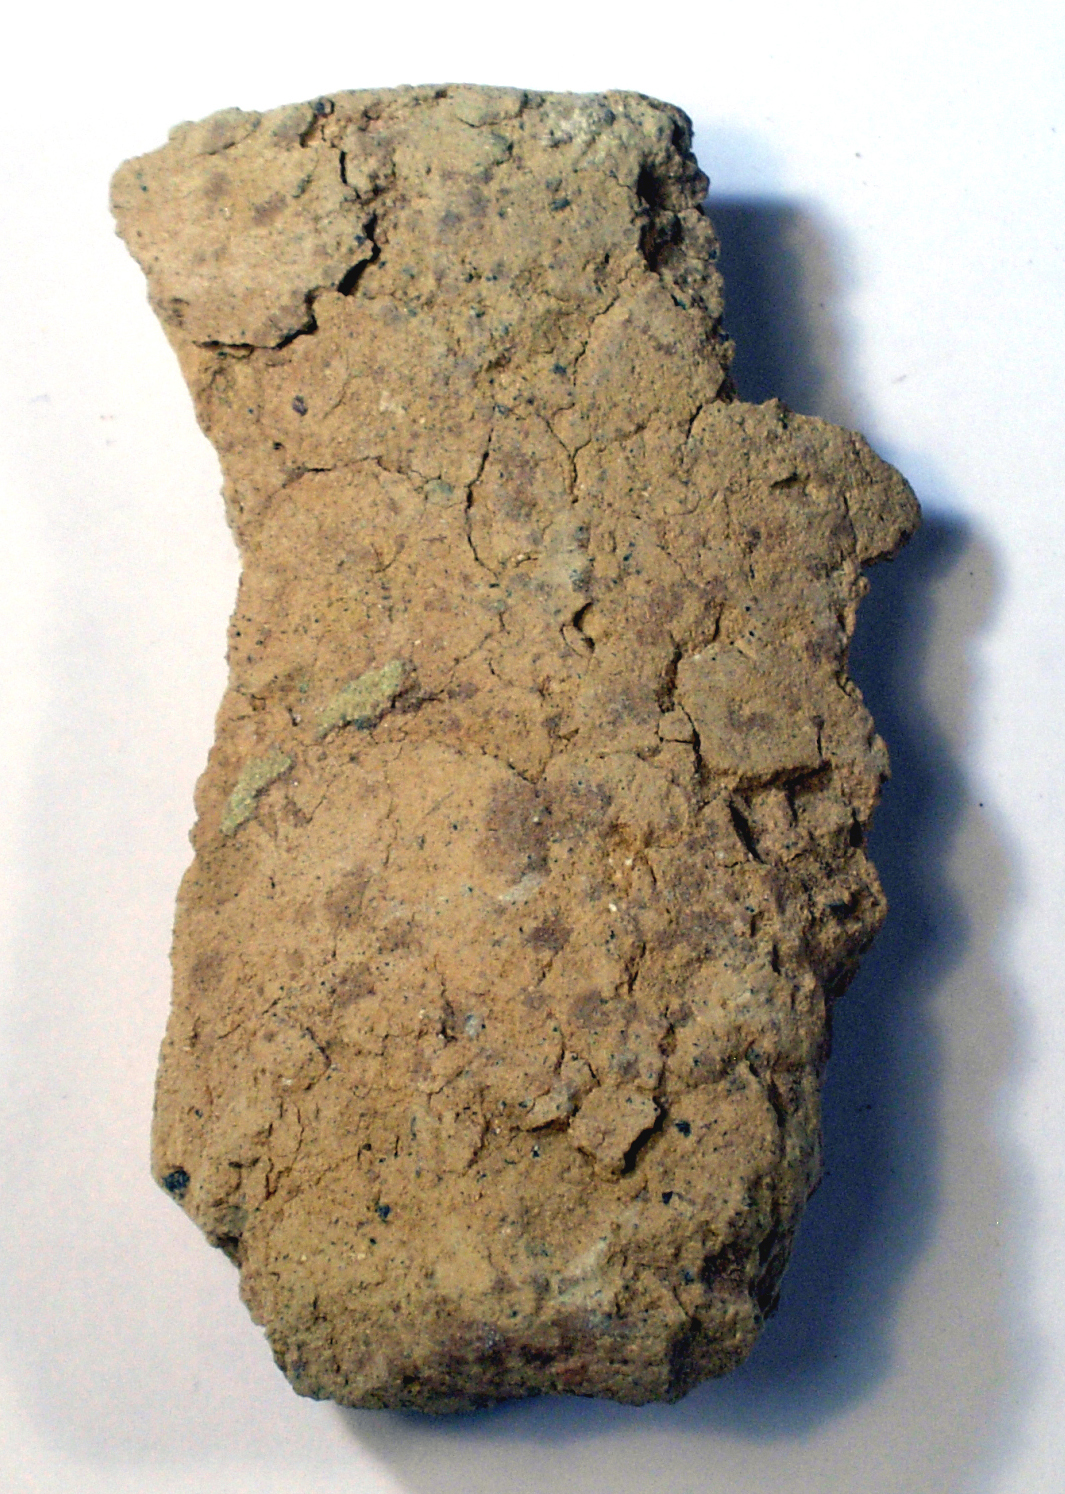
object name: fragment, clay section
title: Faience workshop refuse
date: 1802-1450 BCE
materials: clay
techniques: firing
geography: egypt